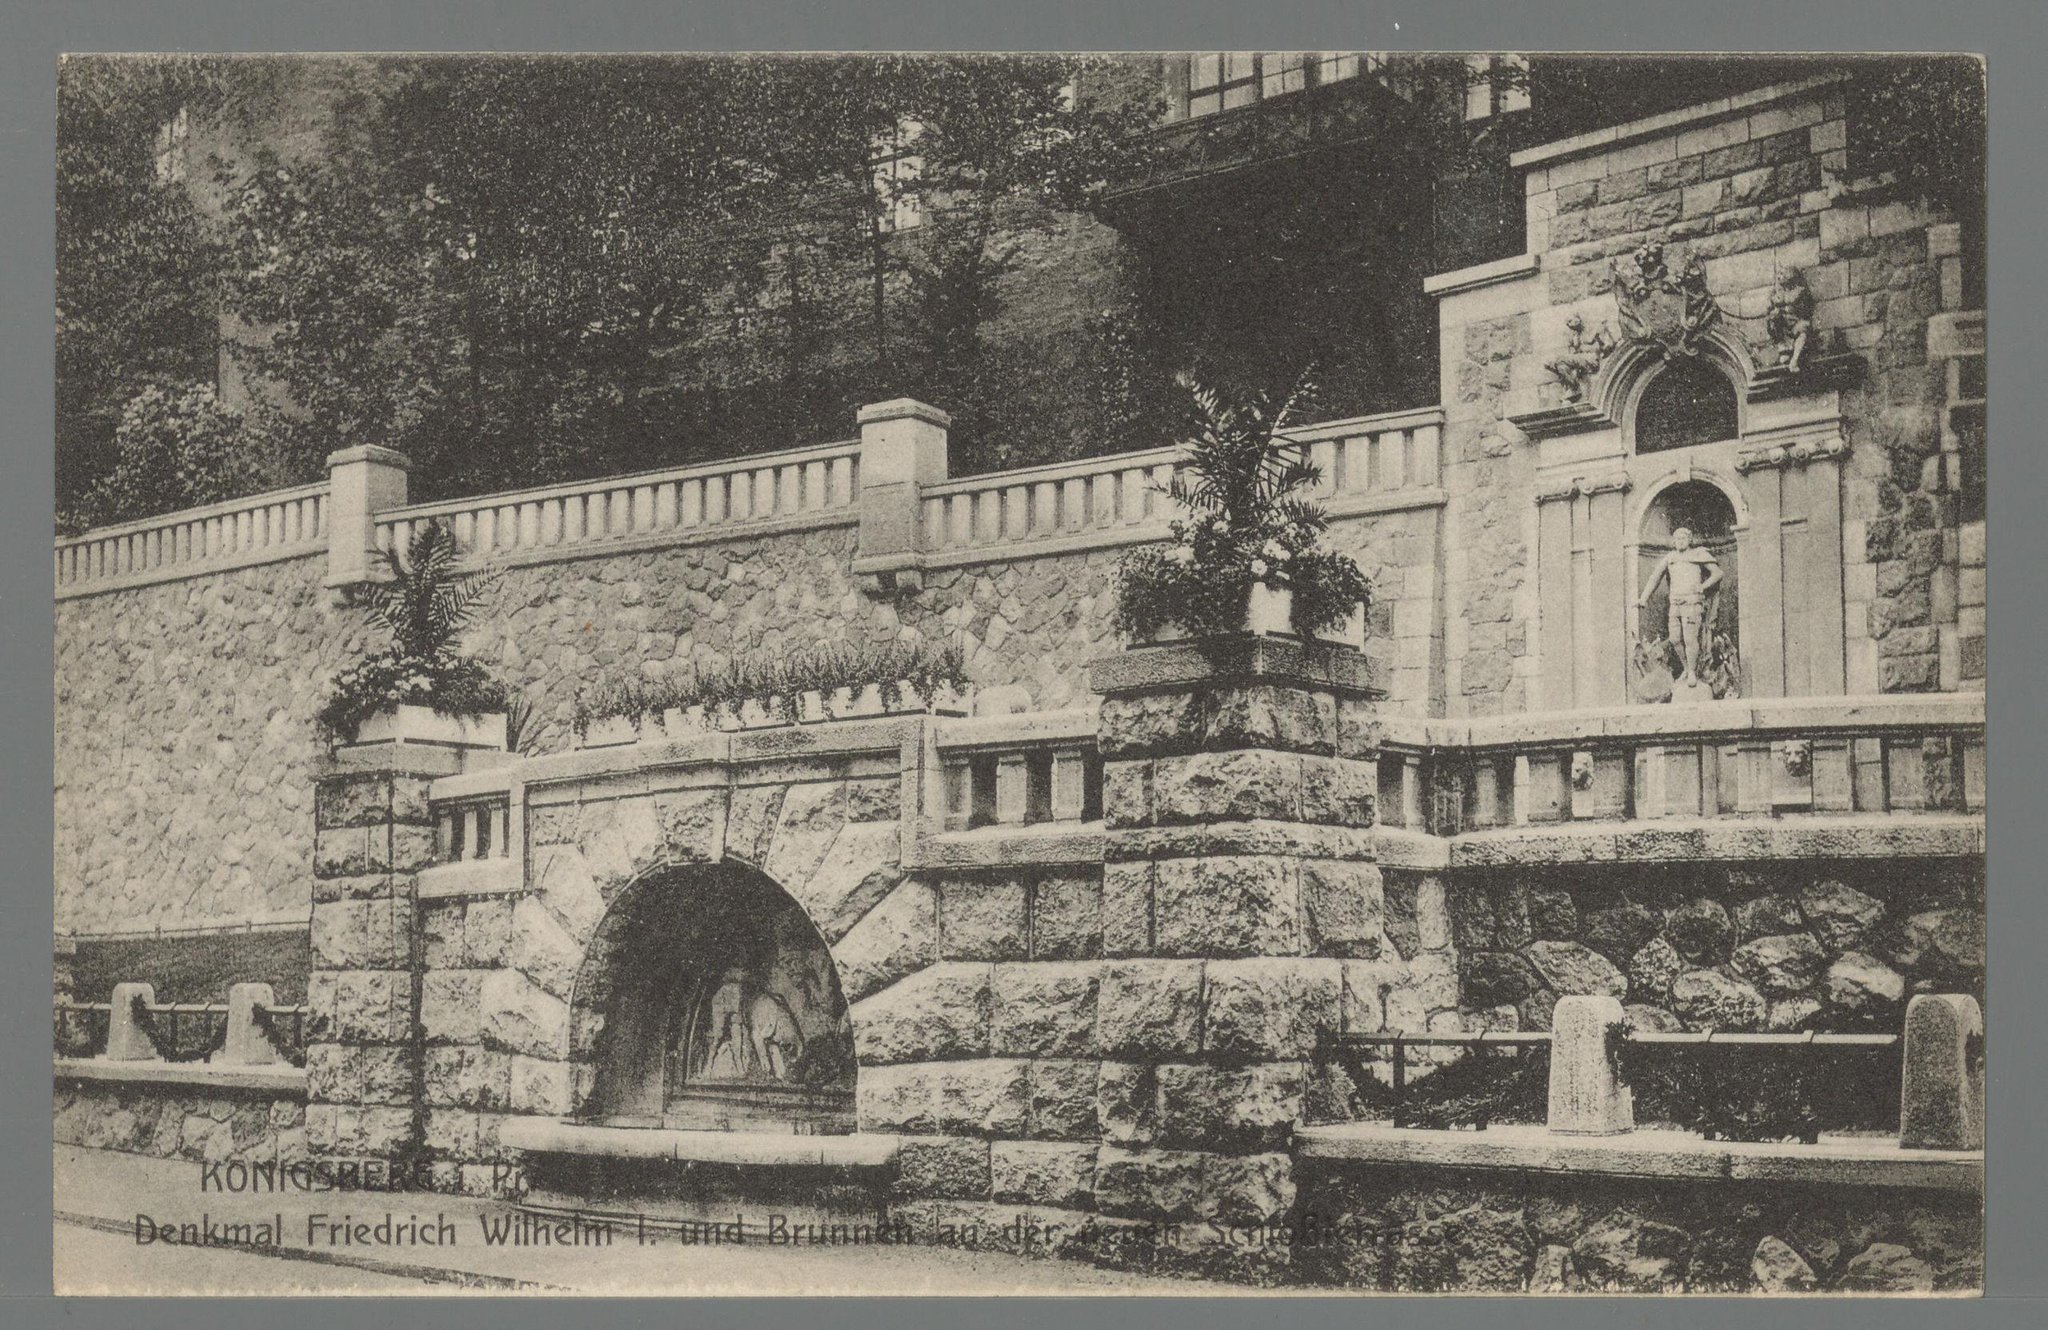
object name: ansichtkaart, prentbriefkaart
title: Königsberg i. Pr. Denkmal Friedrich Wilhelm I. und Brunnen an der neuen Schloβterrasse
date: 1905-1930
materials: cardboard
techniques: photograph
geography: königsberg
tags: berlin, castle, monument, statue